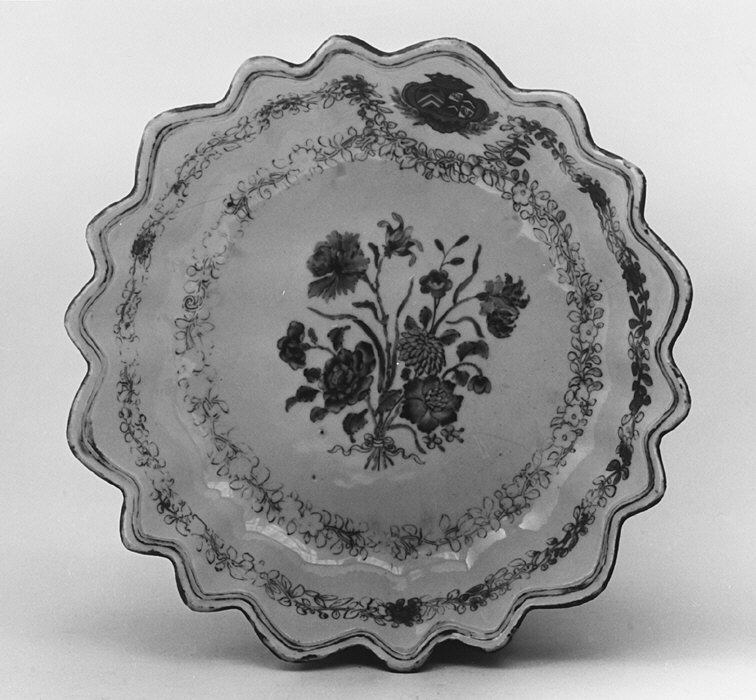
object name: dish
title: Deep dish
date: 1740-1750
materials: hard paste porcelain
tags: flowers